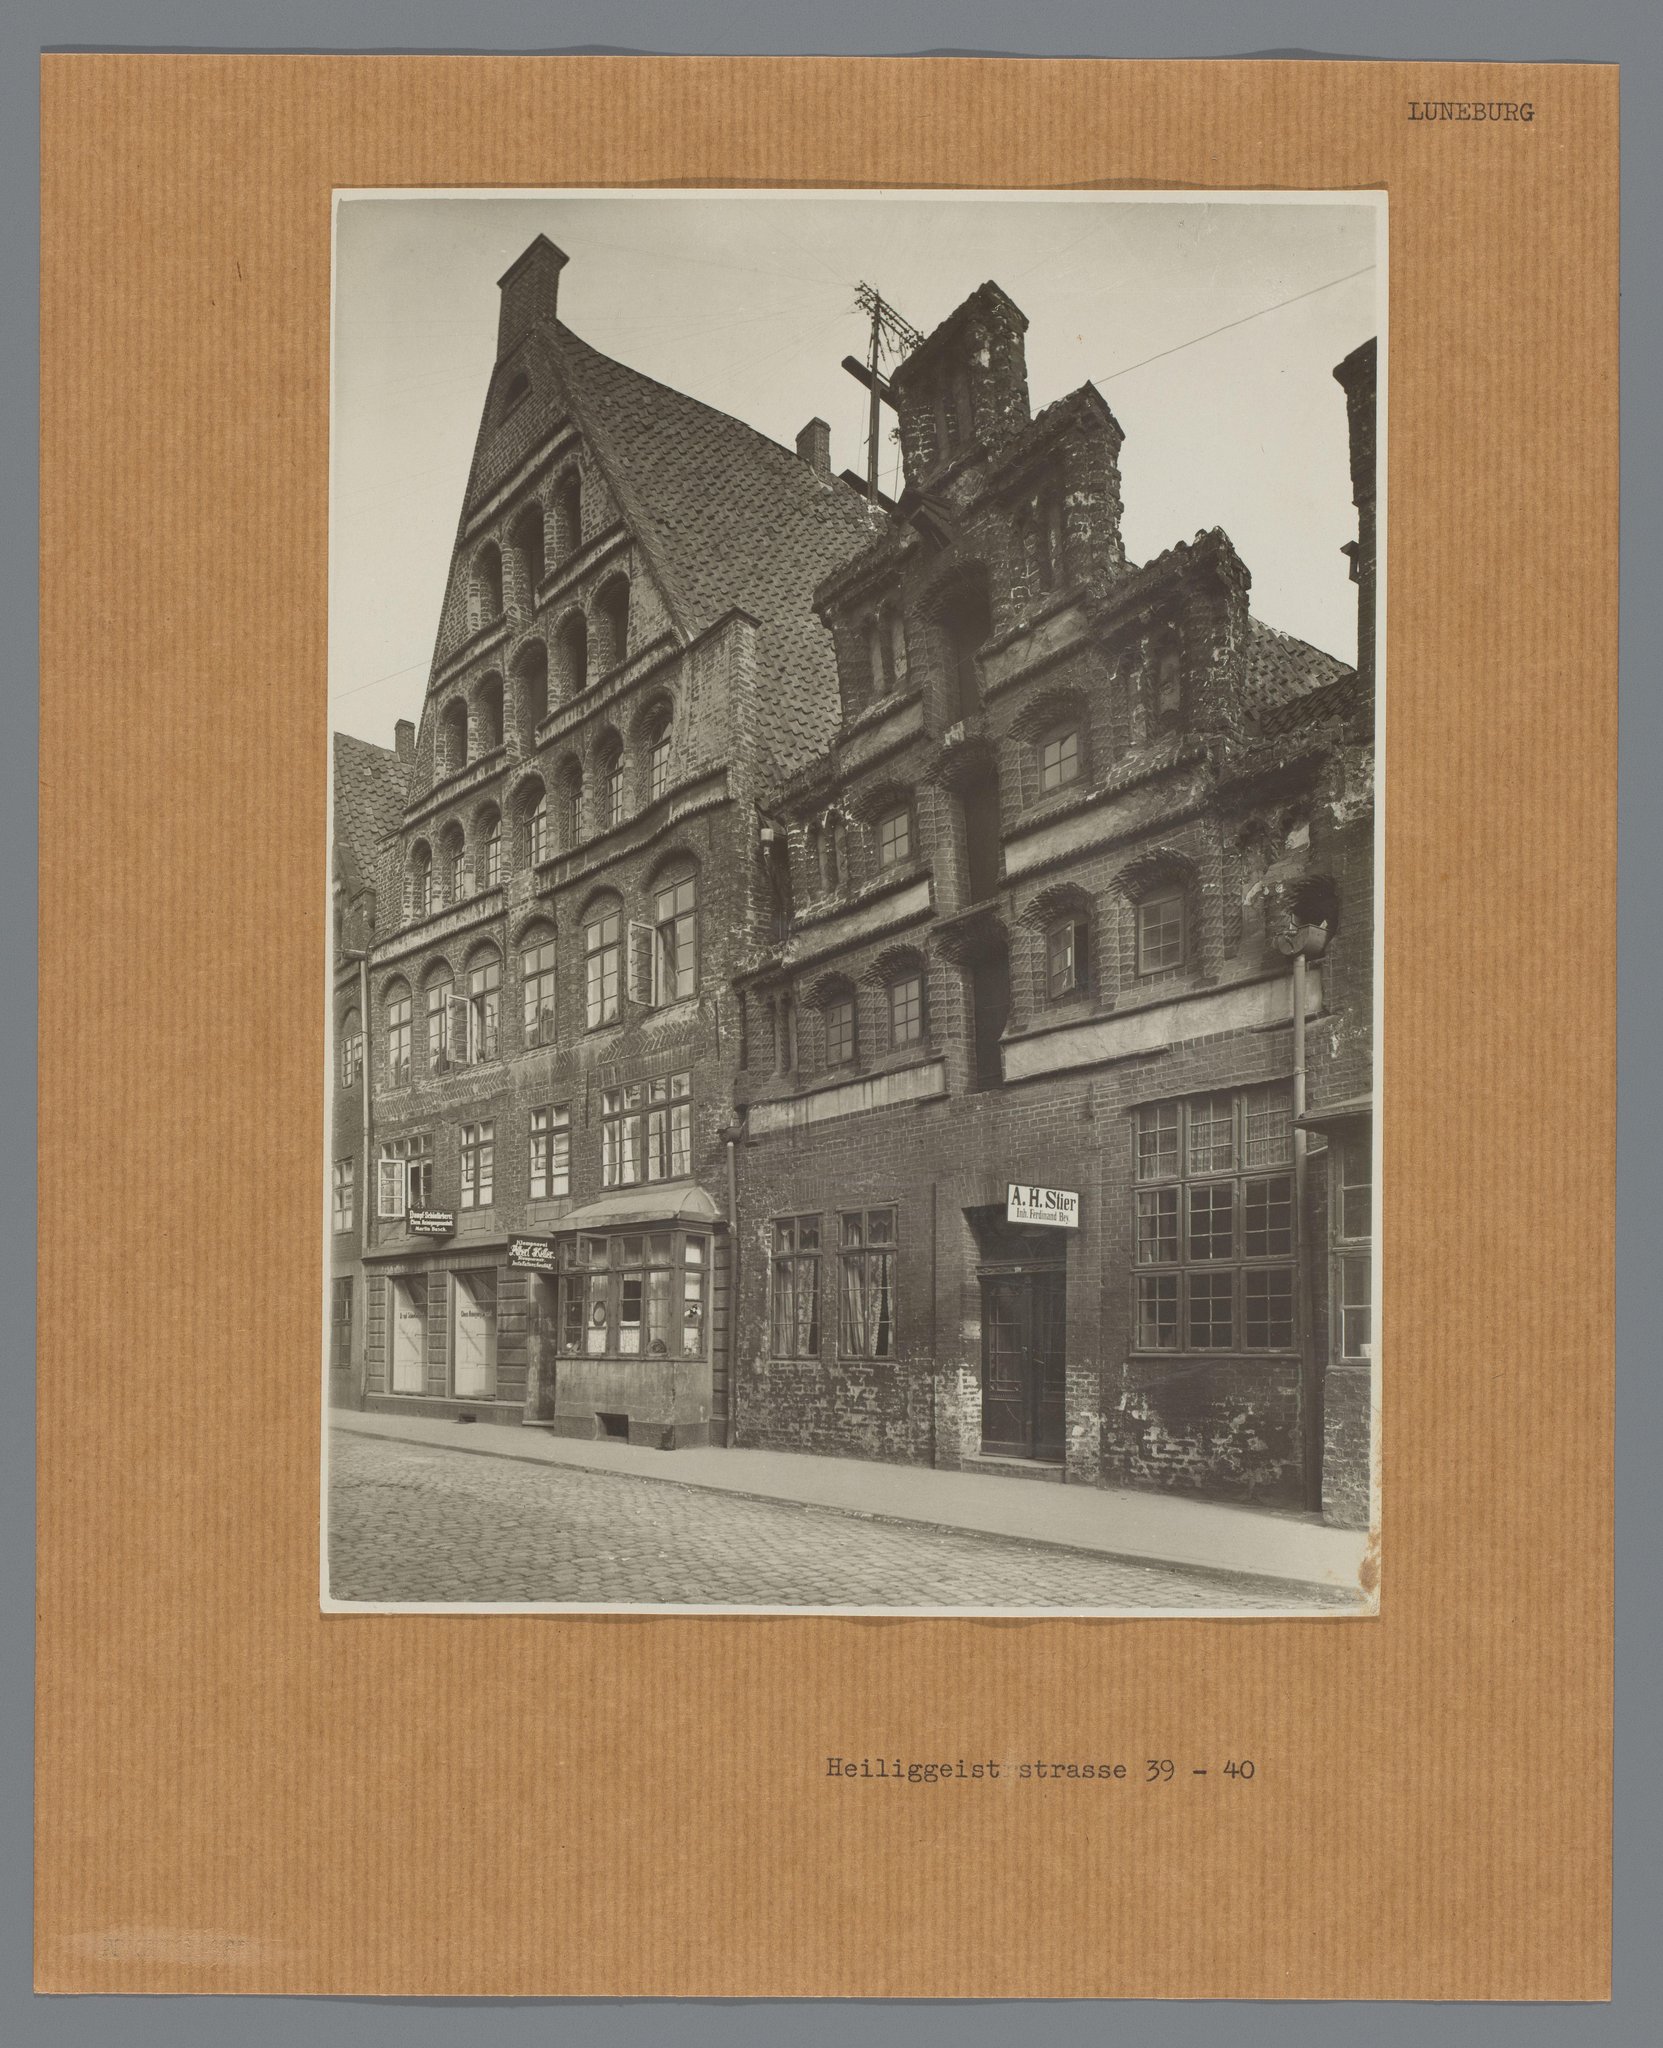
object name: photograph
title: Luneberg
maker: Anonymous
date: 1900-1950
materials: photographic support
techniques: gelatin silver print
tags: lüneburg